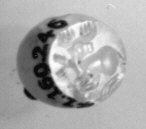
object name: stamp seal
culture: sasanian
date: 201-700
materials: stone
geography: iran or mesopotamia